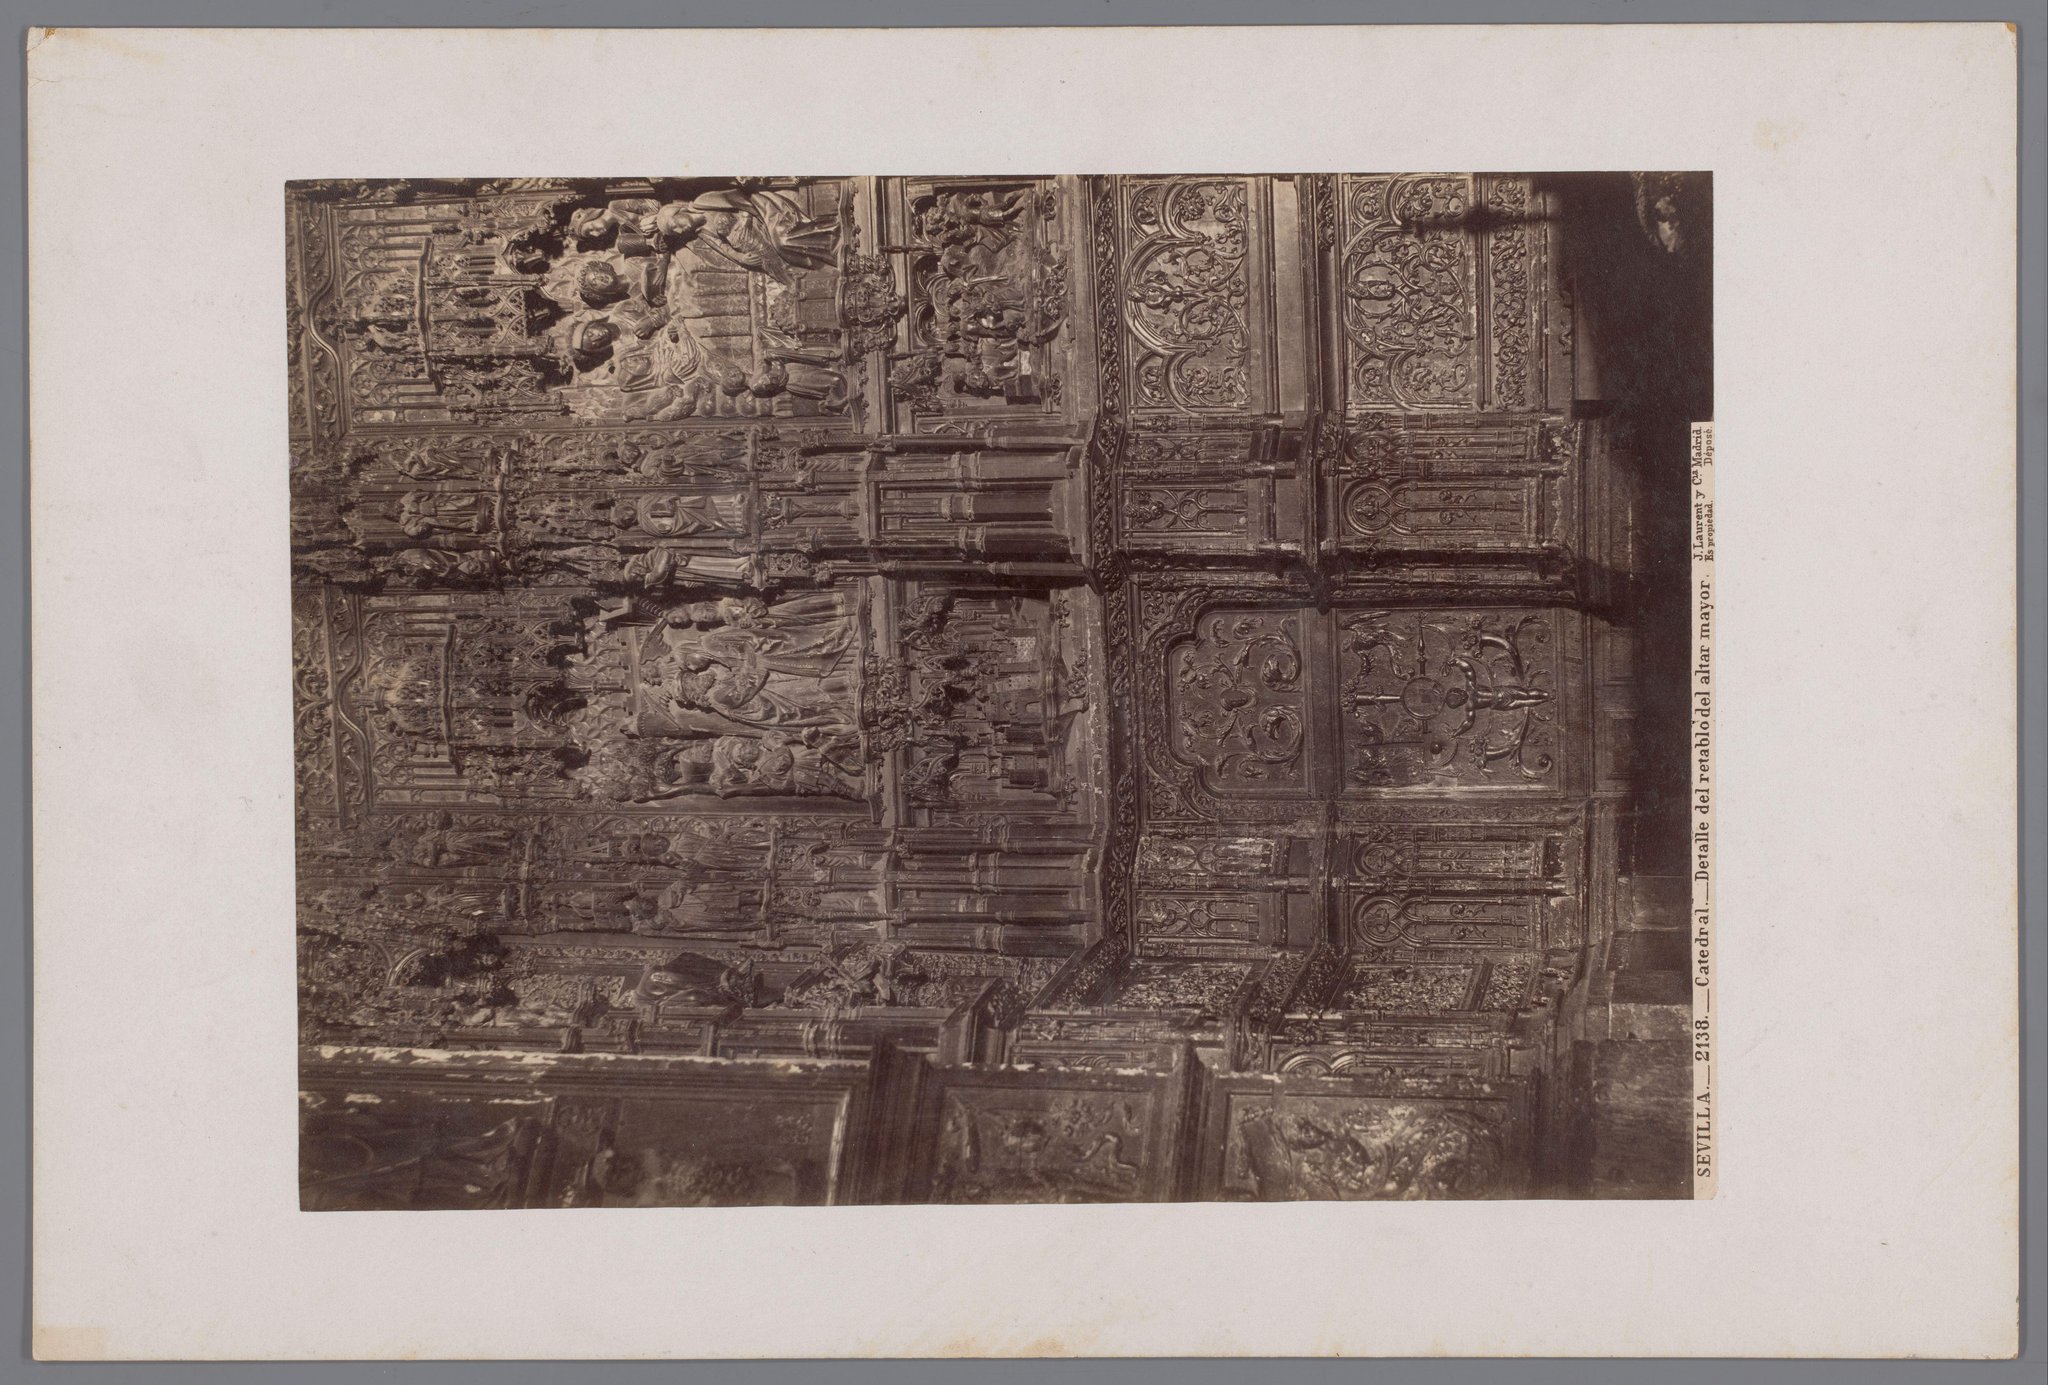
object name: photograph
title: Detail van het retabel van het hoofdaltaar van de kathedraal, Sevilla, Spanje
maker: juan laurent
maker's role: publisher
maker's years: 1816-1896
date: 1857-1890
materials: cardboard, photographic support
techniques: albumen print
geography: madrid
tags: kathedraal van sevilla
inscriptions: caption: ‘SEVILLA._2138._Catedral._Detalle del retablo del altar mayor. J.Laurent y cia. Madrid//Es propiedad. Déposé.’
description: Stenen reliëfs met bijbelse voorstellingen boven- en onderaan plantmotieven. Vergelijk RP-F-00-6078.